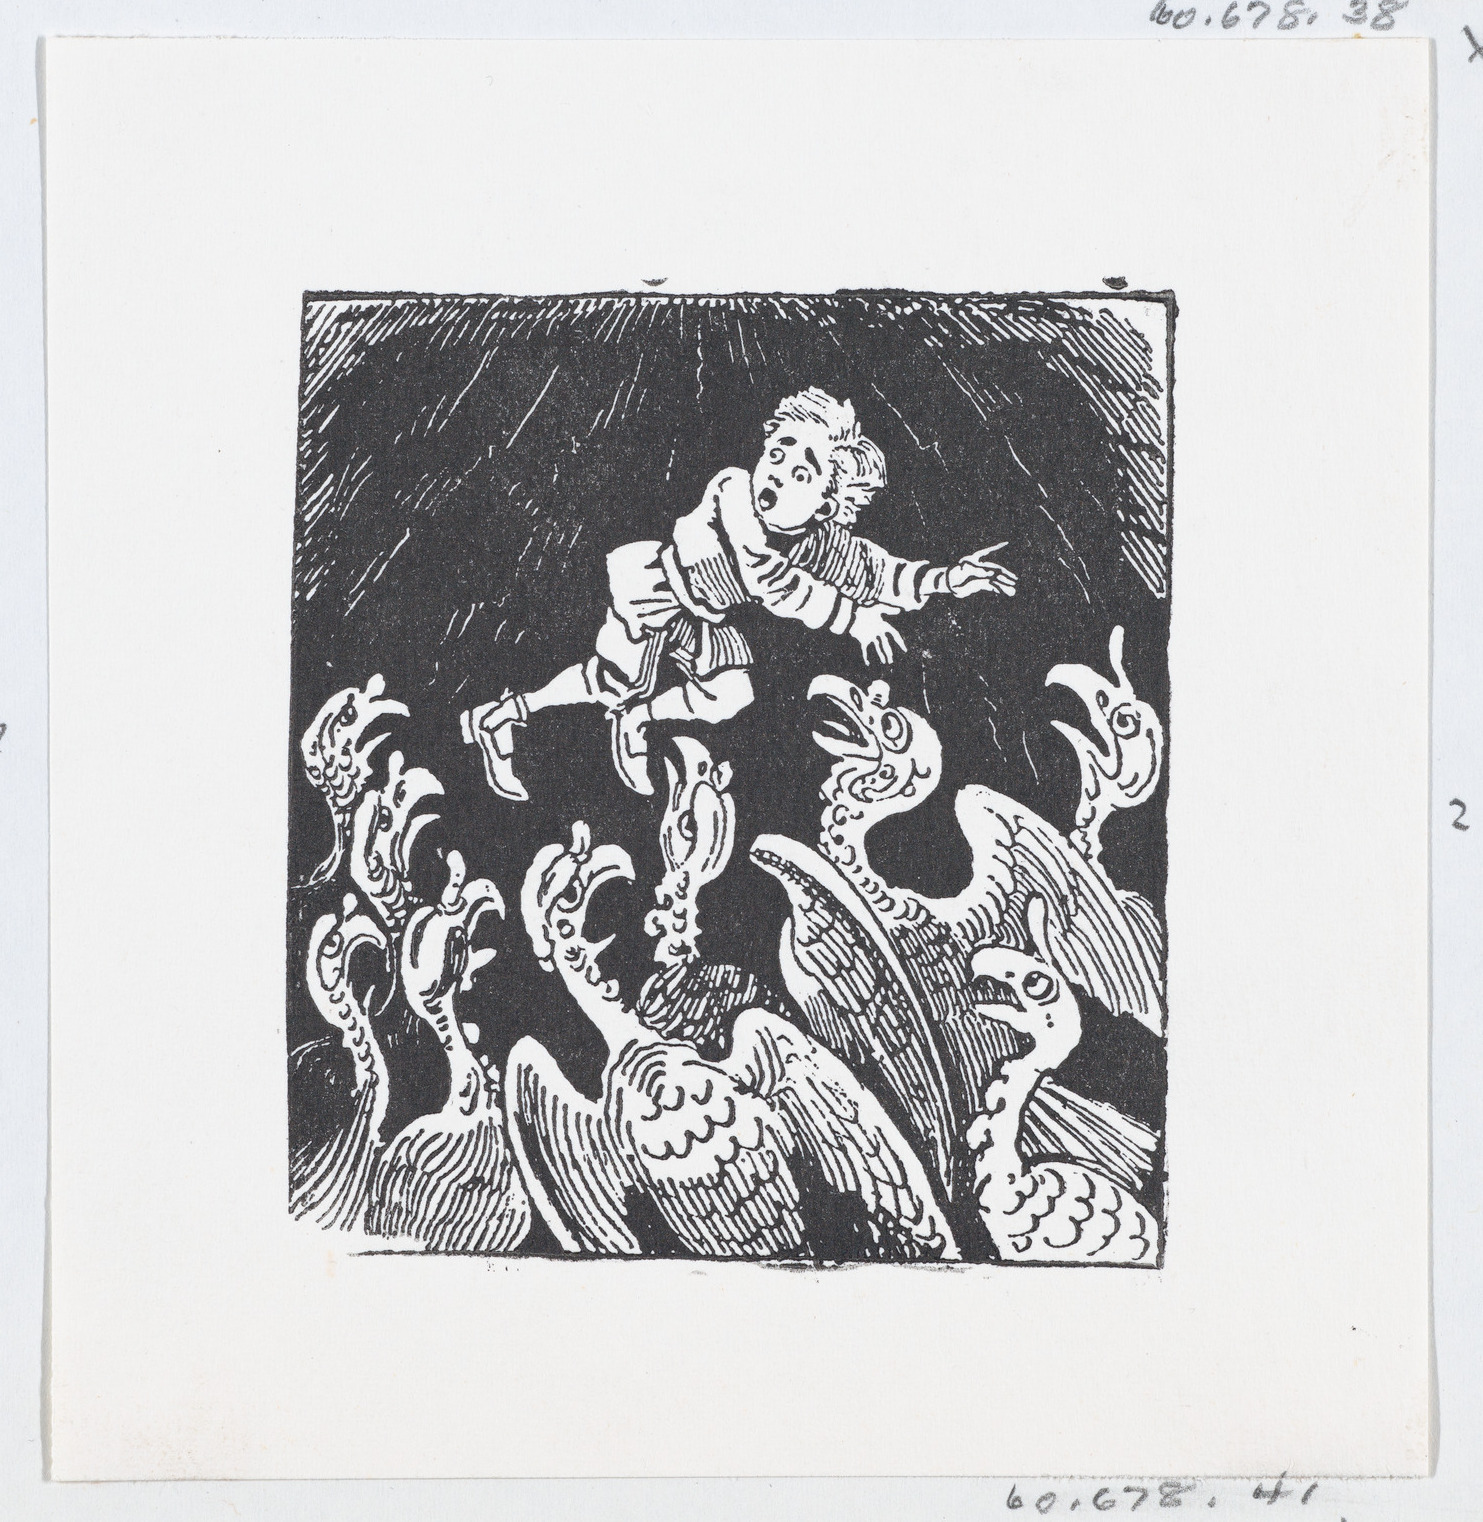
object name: print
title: A small boy being fed to vultures, an illustration to 'The King and His Three Sons'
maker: josé guadalupe posada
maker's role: artist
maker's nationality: mexican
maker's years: 1852-1913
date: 1880-1910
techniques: lithography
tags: birds,fear,boys